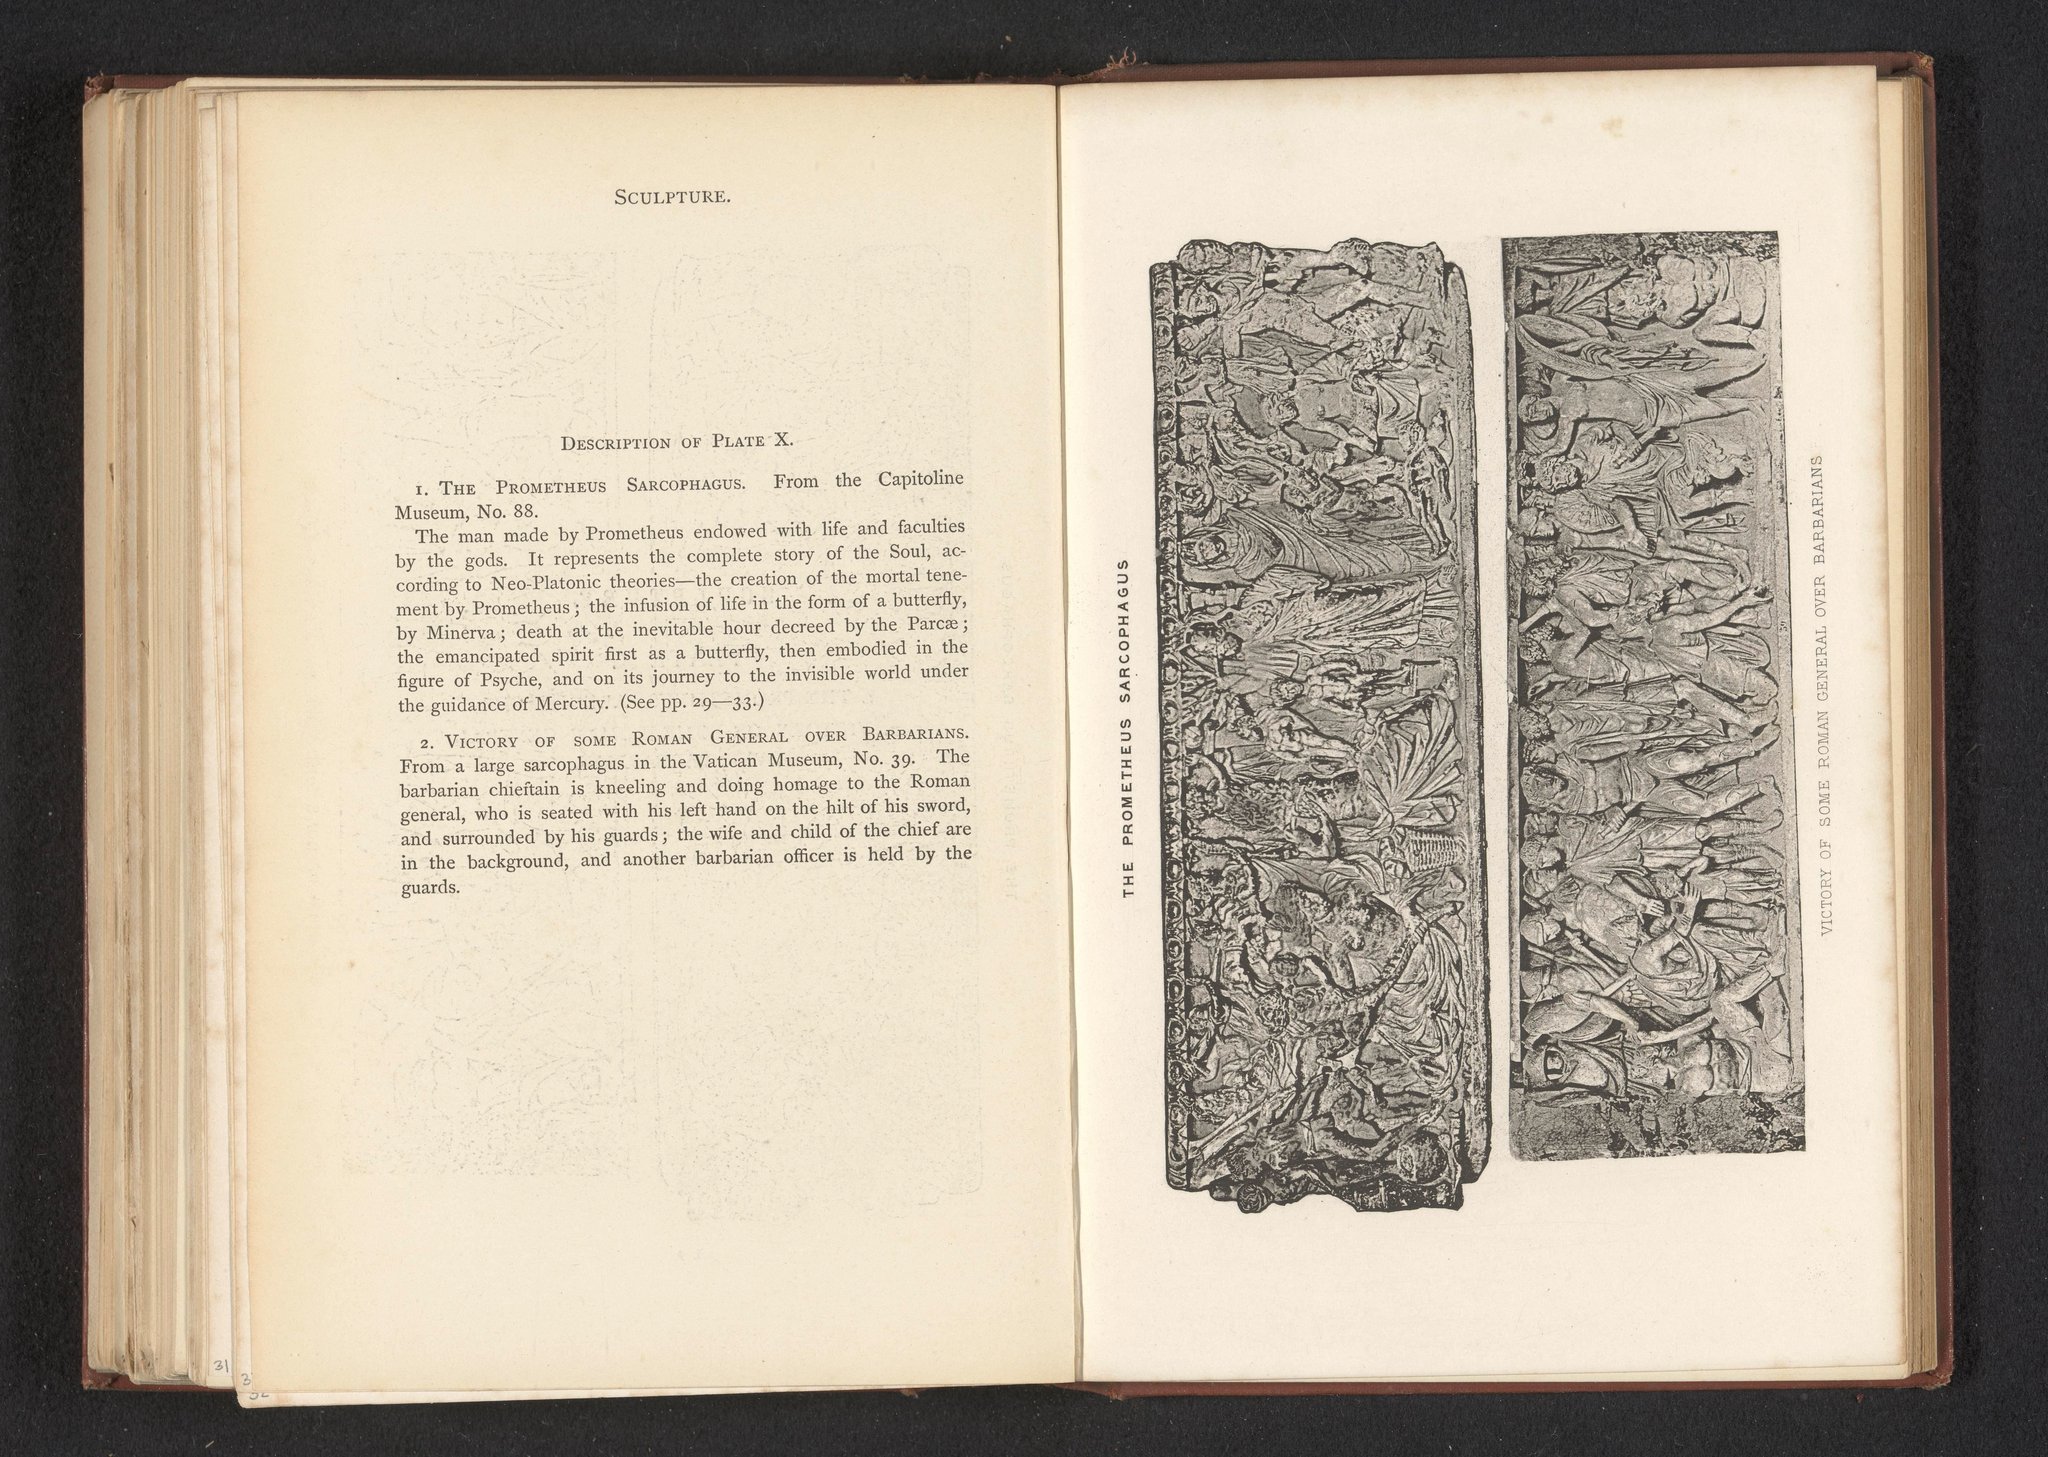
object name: photomechanical print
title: The Prometheus sarcophagus Victory of some Roman general over Barbarians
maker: Anonymous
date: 1867-1877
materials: paper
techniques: photoaquatint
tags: prometheus brings fire to mankind, sarcophagus, decorating 'en relief', appliquéing